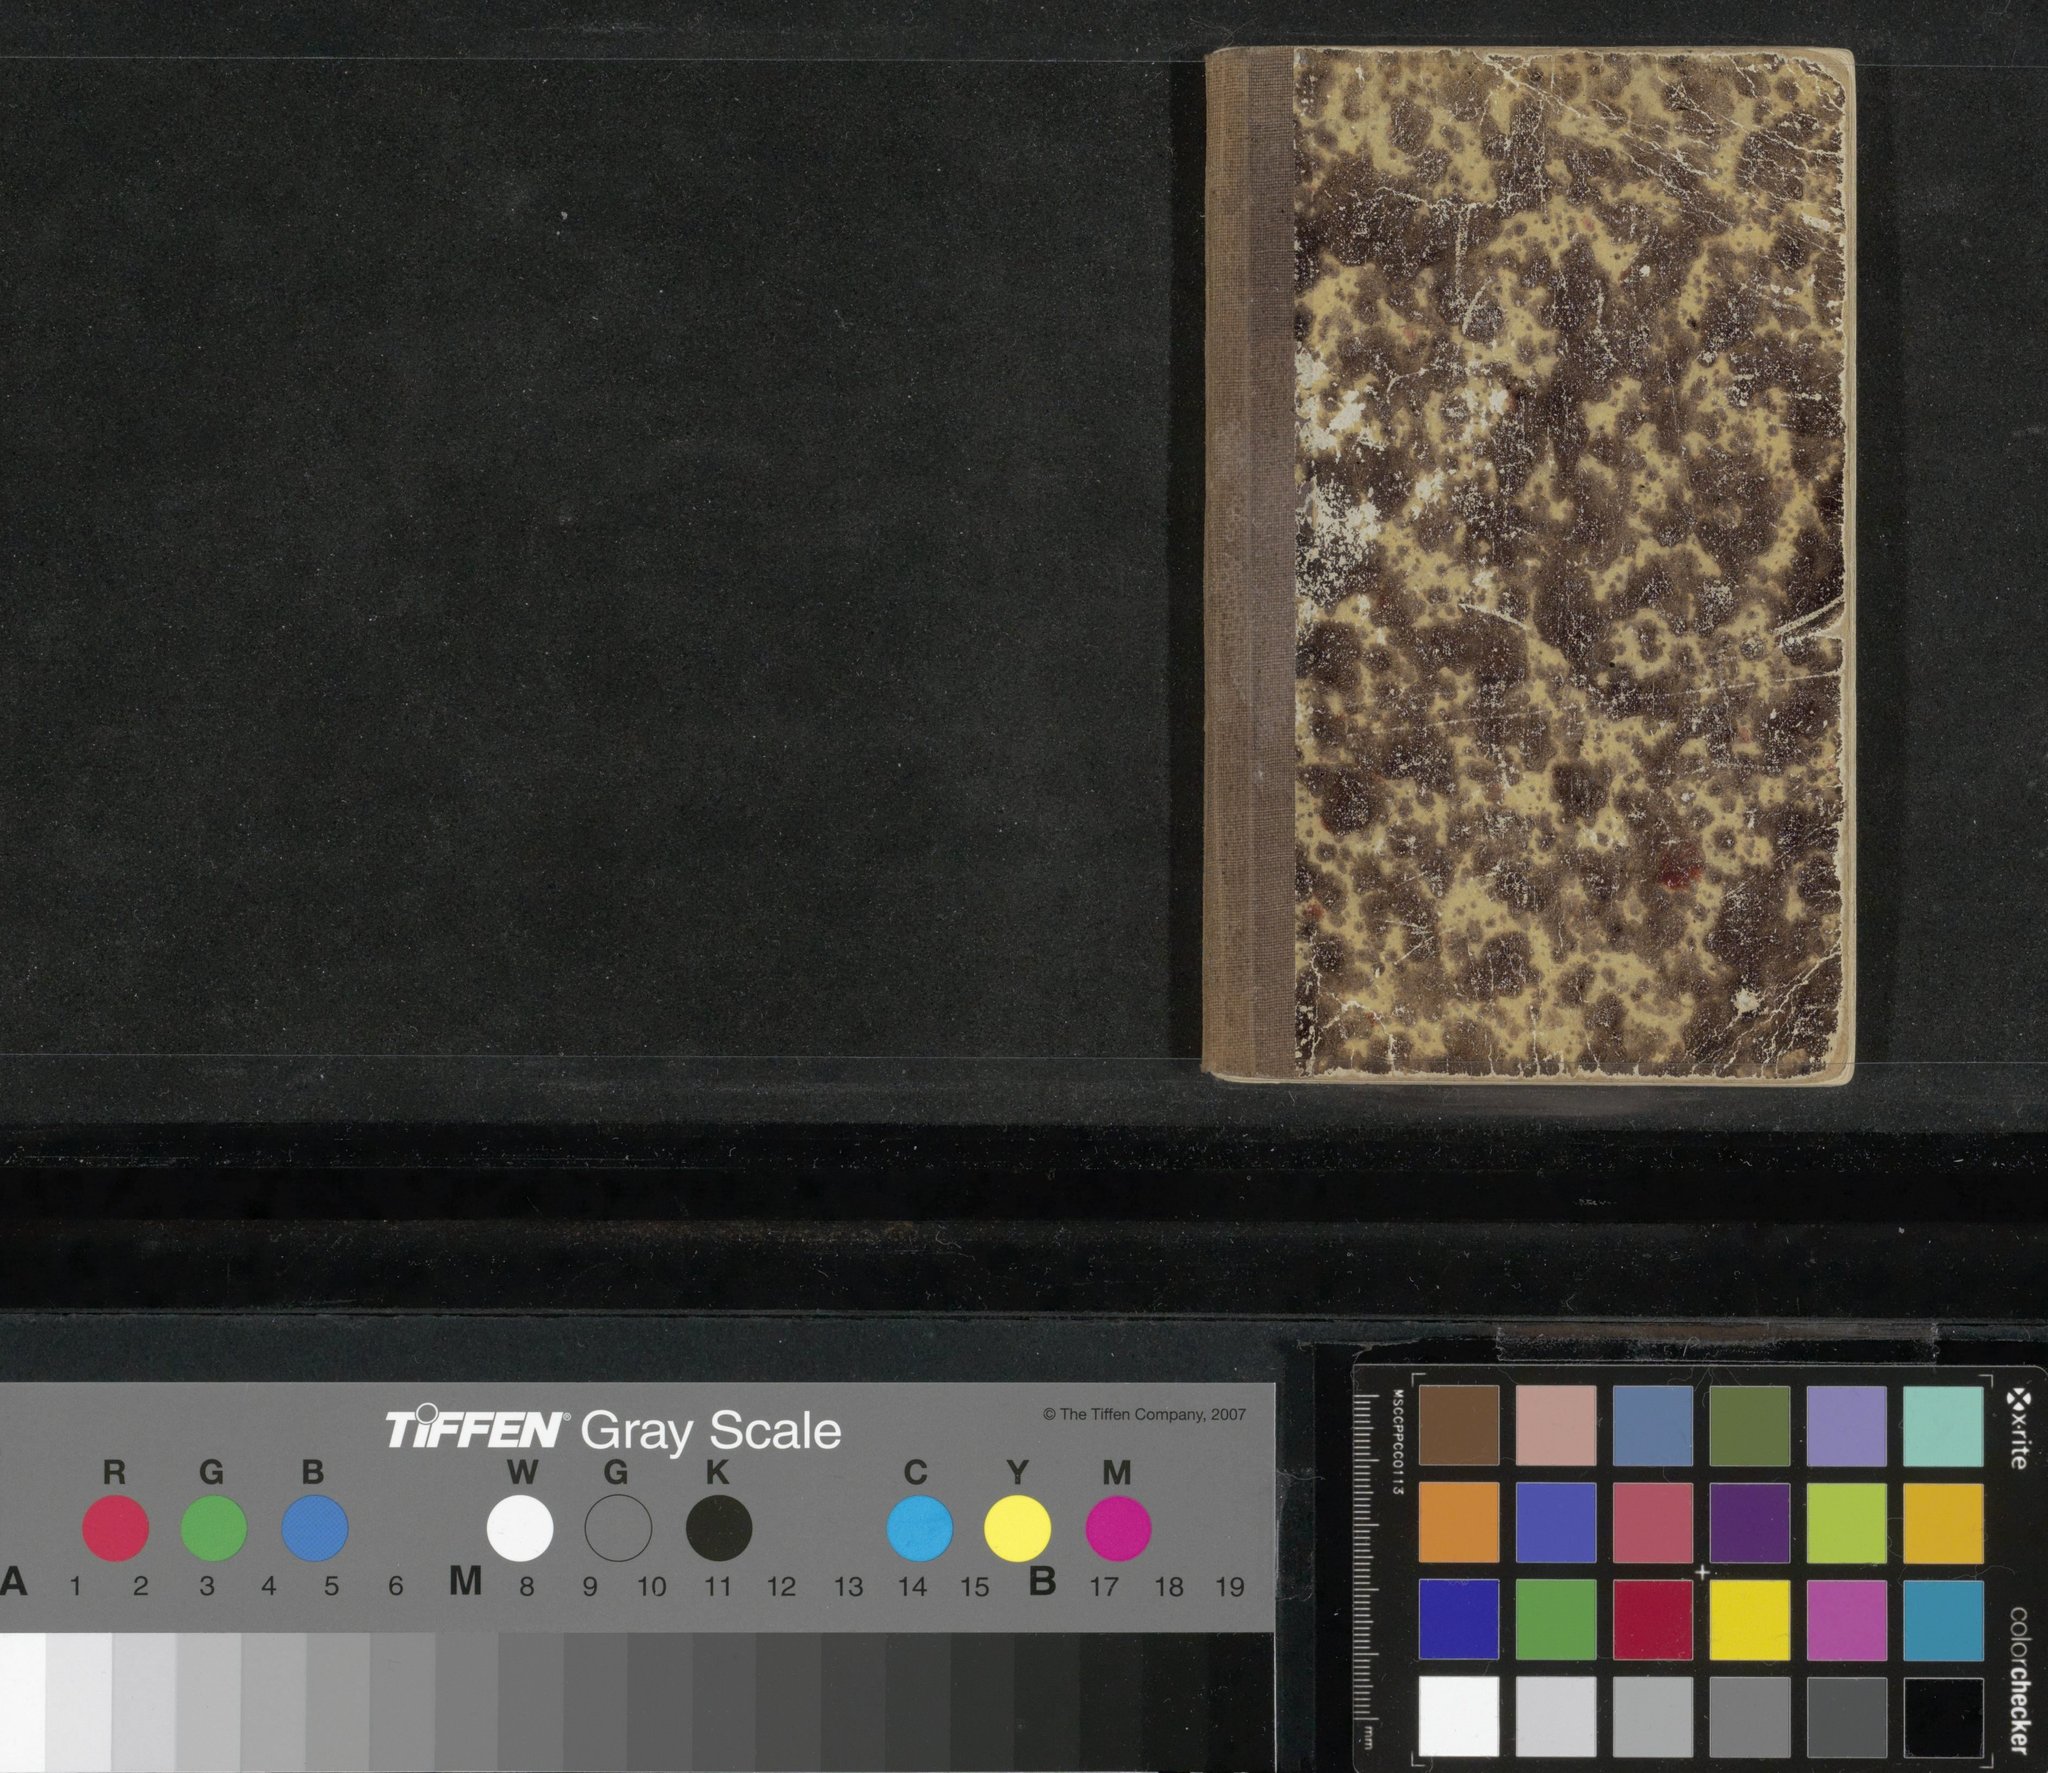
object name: sketchbook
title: Schetsboek met 35 bladen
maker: marius bauer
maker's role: draughtsman, print maker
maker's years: 1867-1932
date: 1810-1891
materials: cardboard, chalk, charcoal, linen, paper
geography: paris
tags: female dancer, architecture, street (+ city(-scape) with figures, staffage), paris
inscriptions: retailer's mark: ‘Magazijn van/ Papier/ Kantoor-/ H.J.T. Matveld/ 2E Wagenstraat, 127/ Teeken- &/ Schilderbehoeften’, collector's mark: Lugt 2228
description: Schetsboek bestaande uit 35 bladen met stadsgezichten van Parijs, danseressen in de Moulin Rouge en ridders te paard in harnas uit het Musée des Invalides.